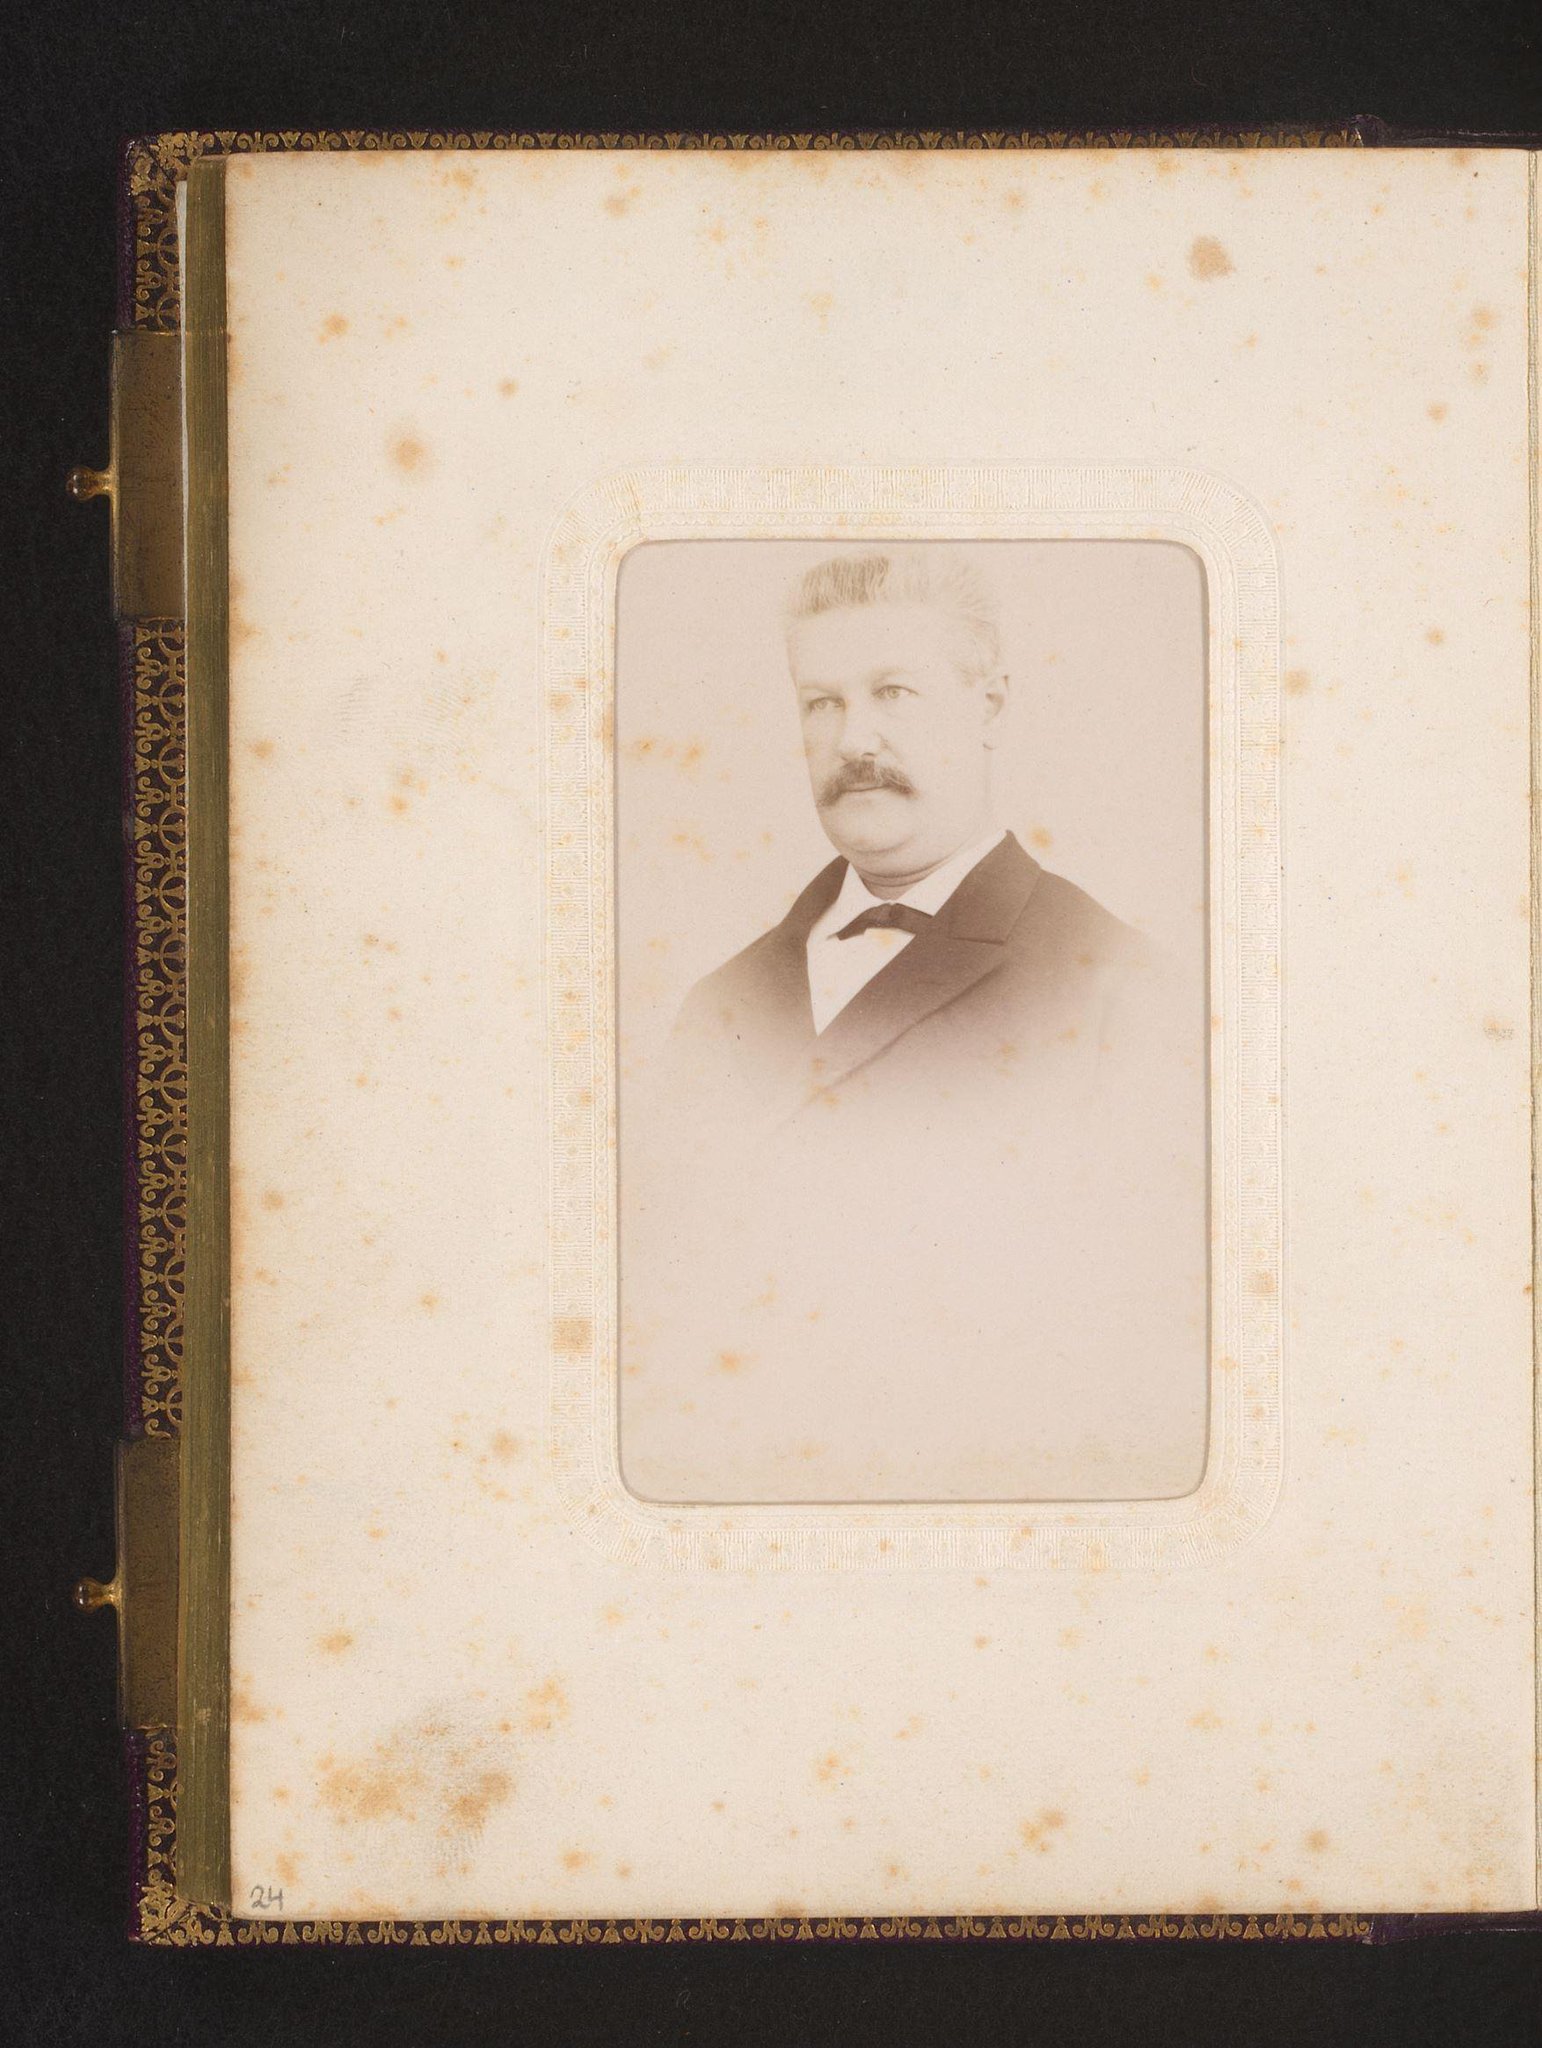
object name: album leaf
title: Portret van een man met snor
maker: Anonymous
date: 1860-1900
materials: cardboard, photographic support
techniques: albumen print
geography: france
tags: moustache, historical persons